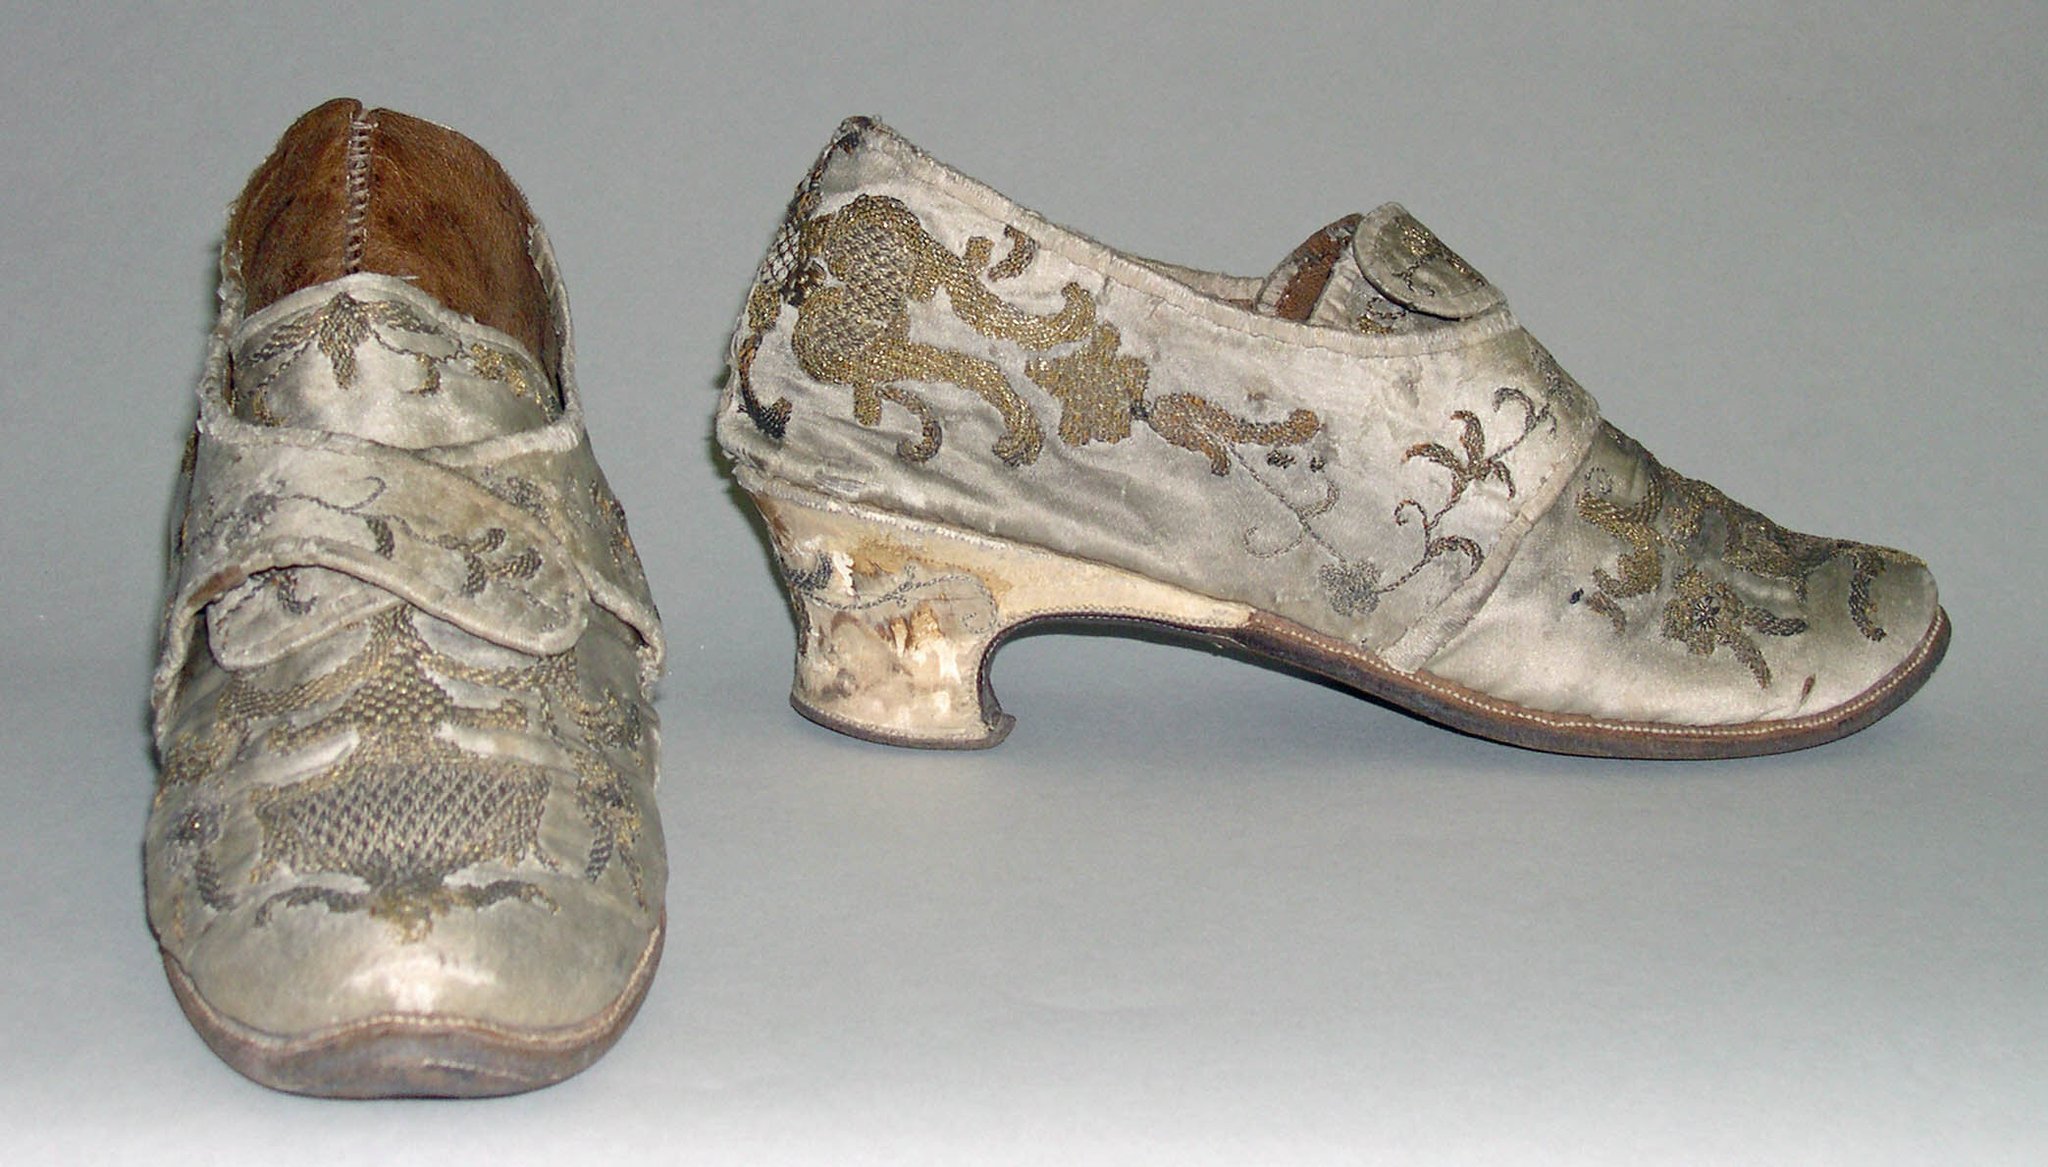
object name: shoe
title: Shoes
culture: european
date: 1720-1740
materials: leather, silk, wood